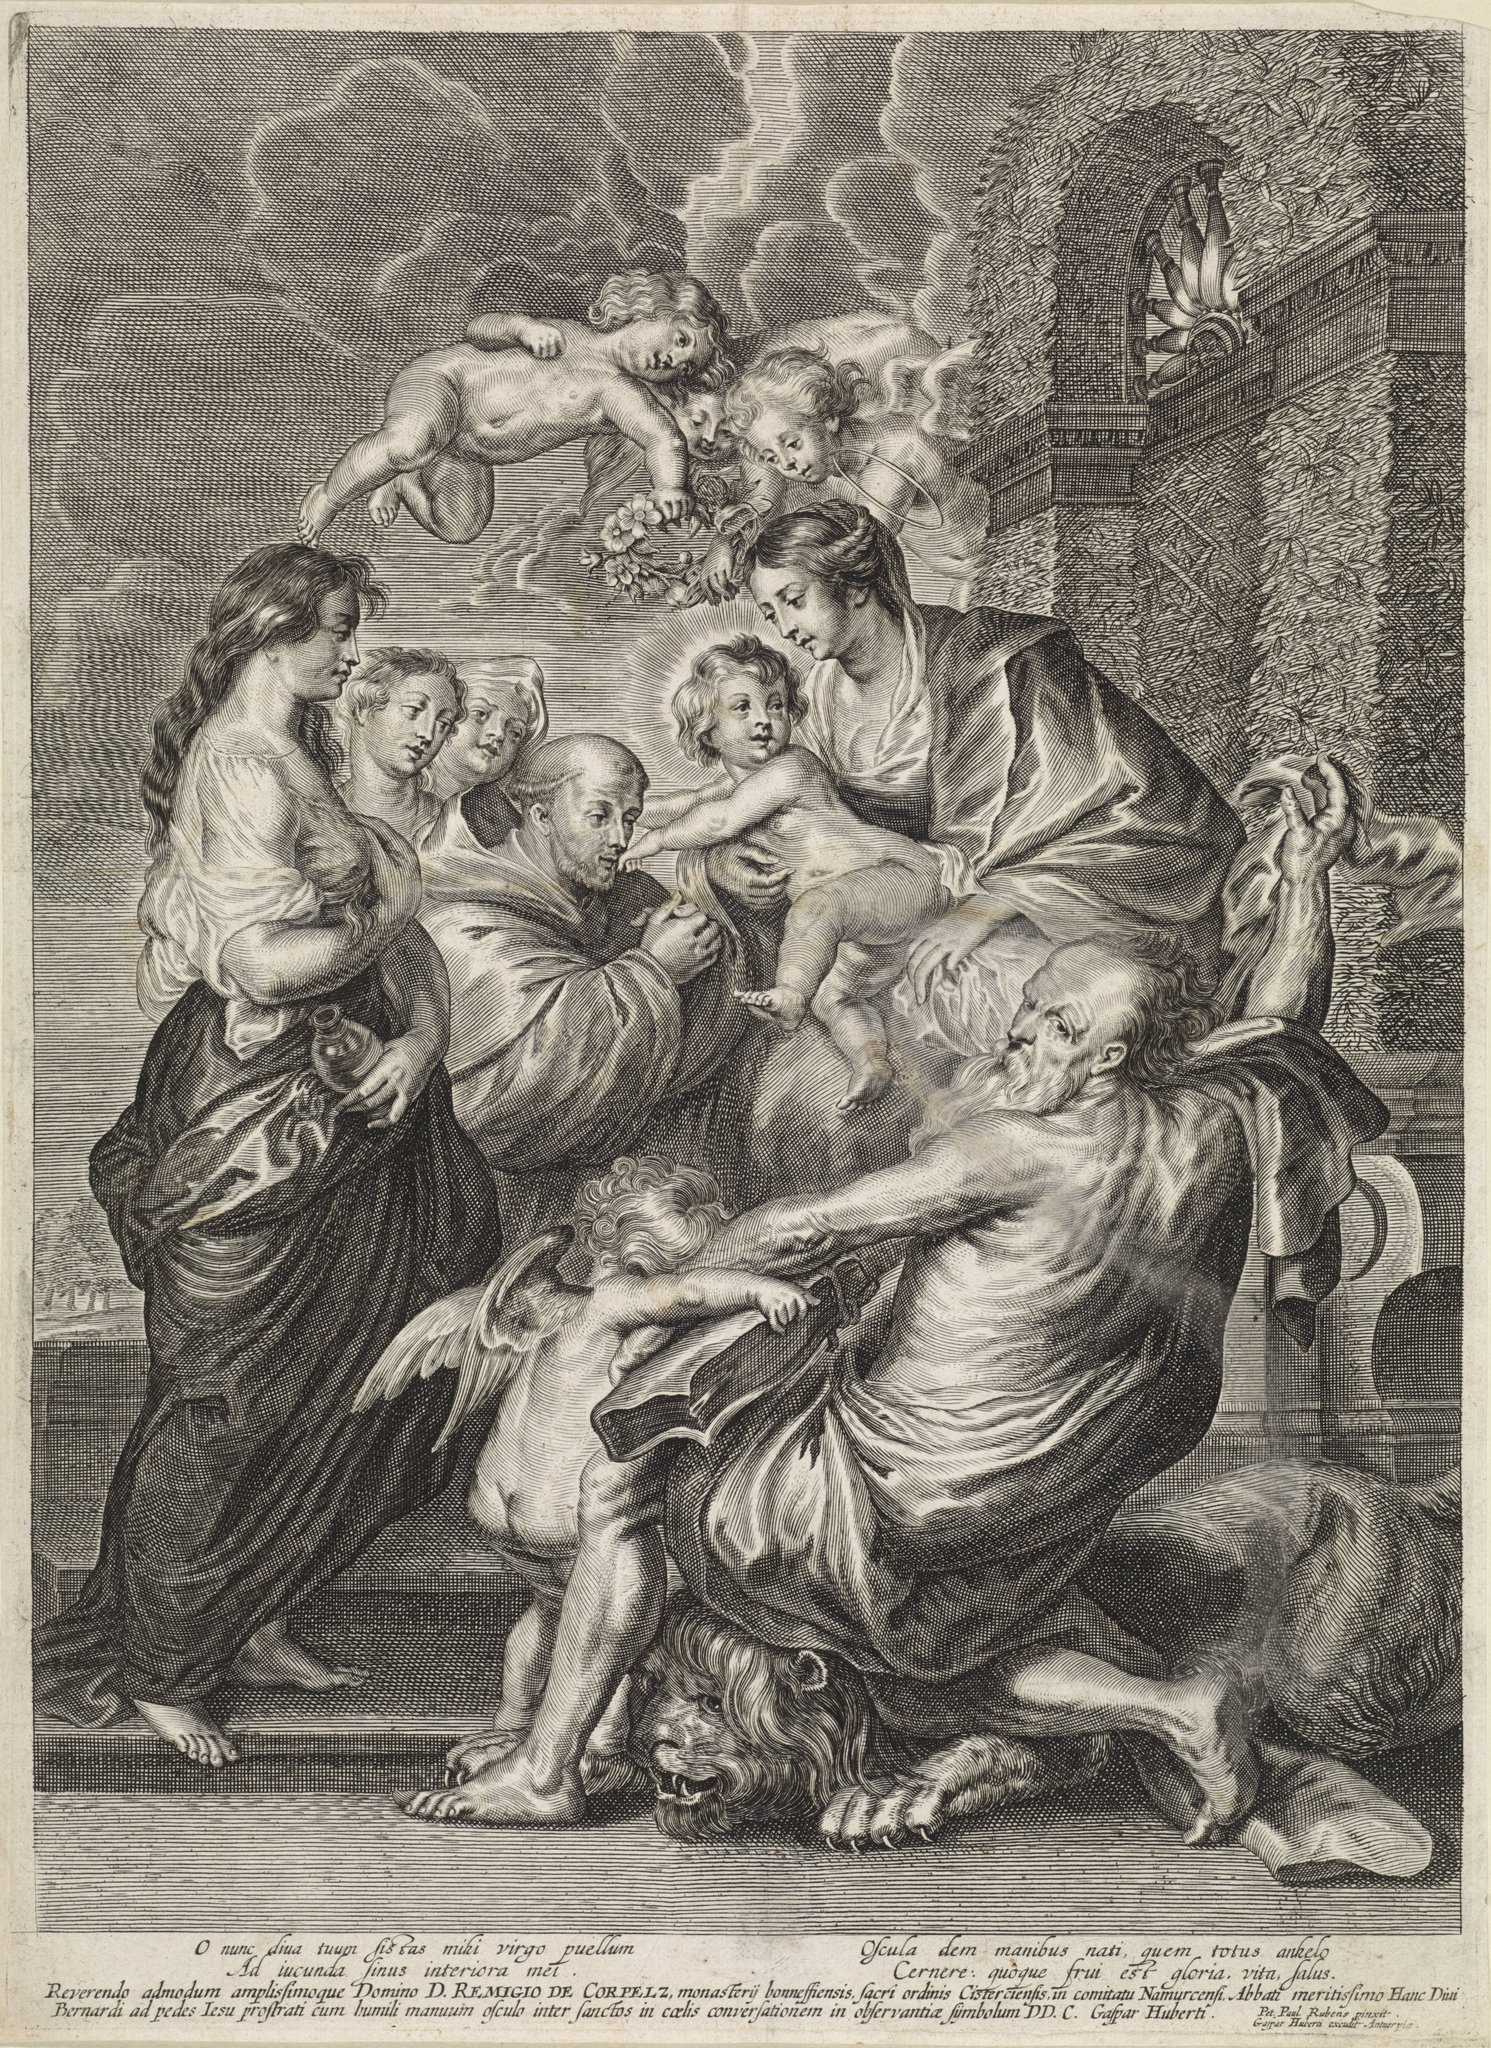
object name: print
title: Maria met Christuskind, omringd door heiligen en engelen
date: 1661-1684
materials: paper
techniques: engraving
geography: antwerp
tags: the monk and hermit jerome (hieronymus); possible attributes: book, cardinal's hat, crucifix, hour-glass, lion, skull, stone, madonna: i.e. mary with the christ-child (+ donor(s), supplicant(s), whether or not with patron saint(s)), the penitent harlot mary magdalene; possible attributes: book (or scroll), crown, crown of thorns, crucifix, jar of ointment, mirror, musical instrument, palm-branch, rosary, scourge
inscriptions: collector's mark: Lugt 240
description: Maria toont het Christuskind aan de heiligen, onder wie Maria Magdalena, die haar omringen. Drie engelen lauweren het Christuskind. Op de voorgrond de H. Hiëronymus, vergezeld door zijn leeuw, die de bijbel vasthoudt en zijn hand opsteekt. In de marge een onderschrift in het Latijn.